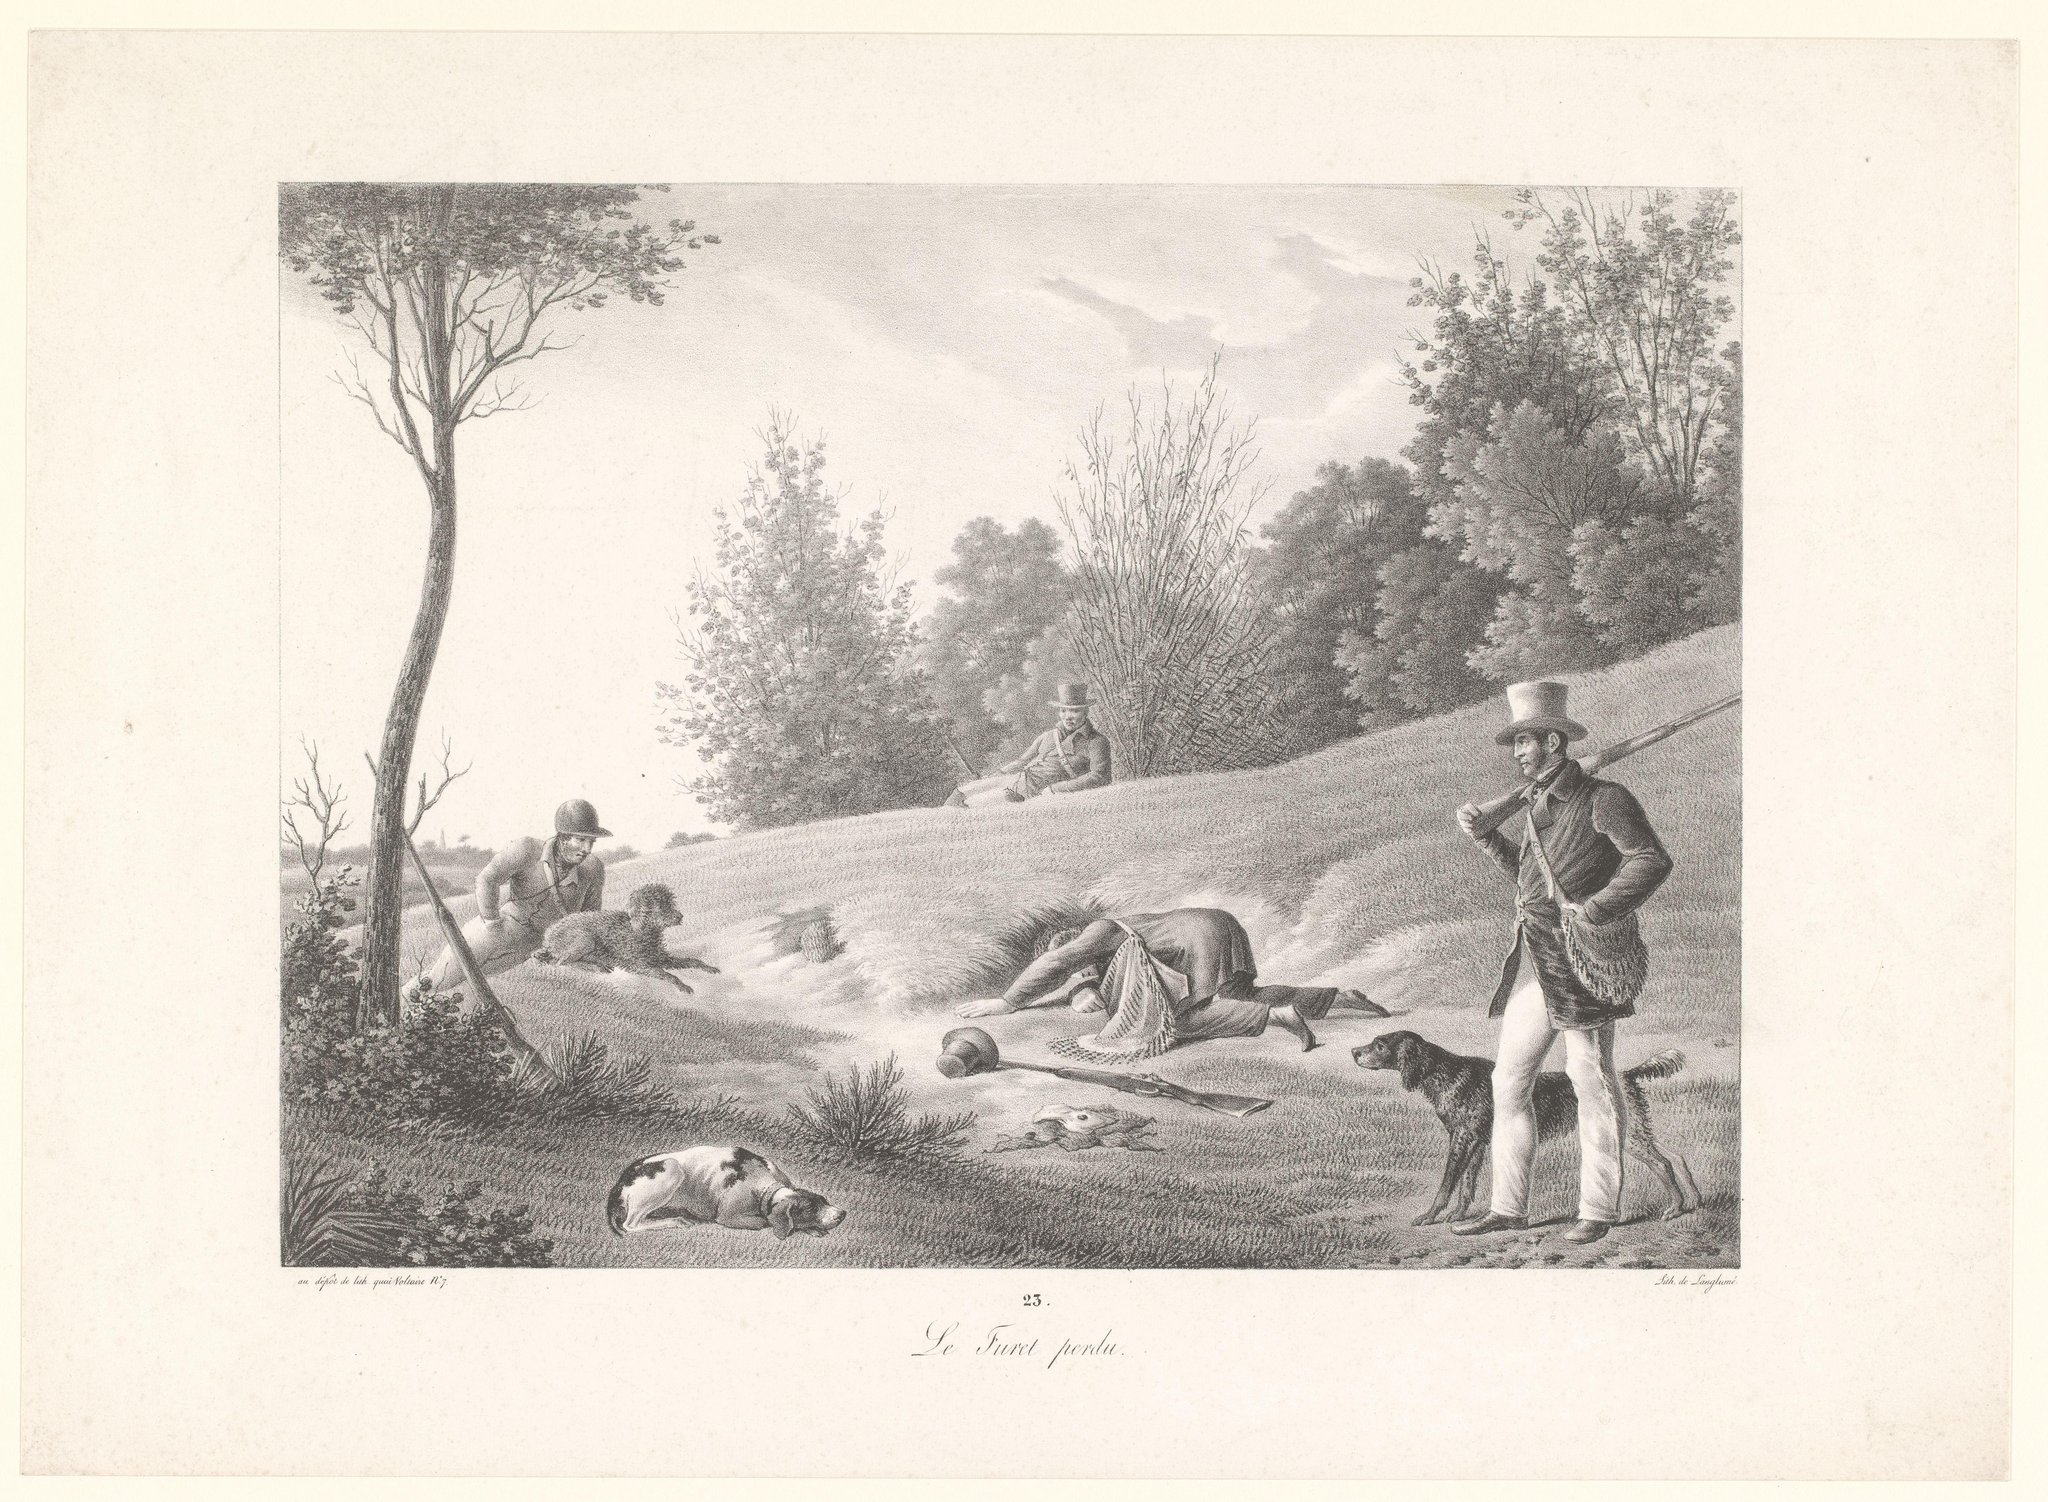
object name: print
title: Jachtvoorstelling met jager die geknield op de grond ligt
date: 1818-1830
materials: paper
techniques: lithograph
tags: hunting dogs, hunter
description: Midden onder genummerd: 23. Jachtvoorstelling met vier jagers waarvan de middelste op de grond ligt met zijn geweer naast zich.